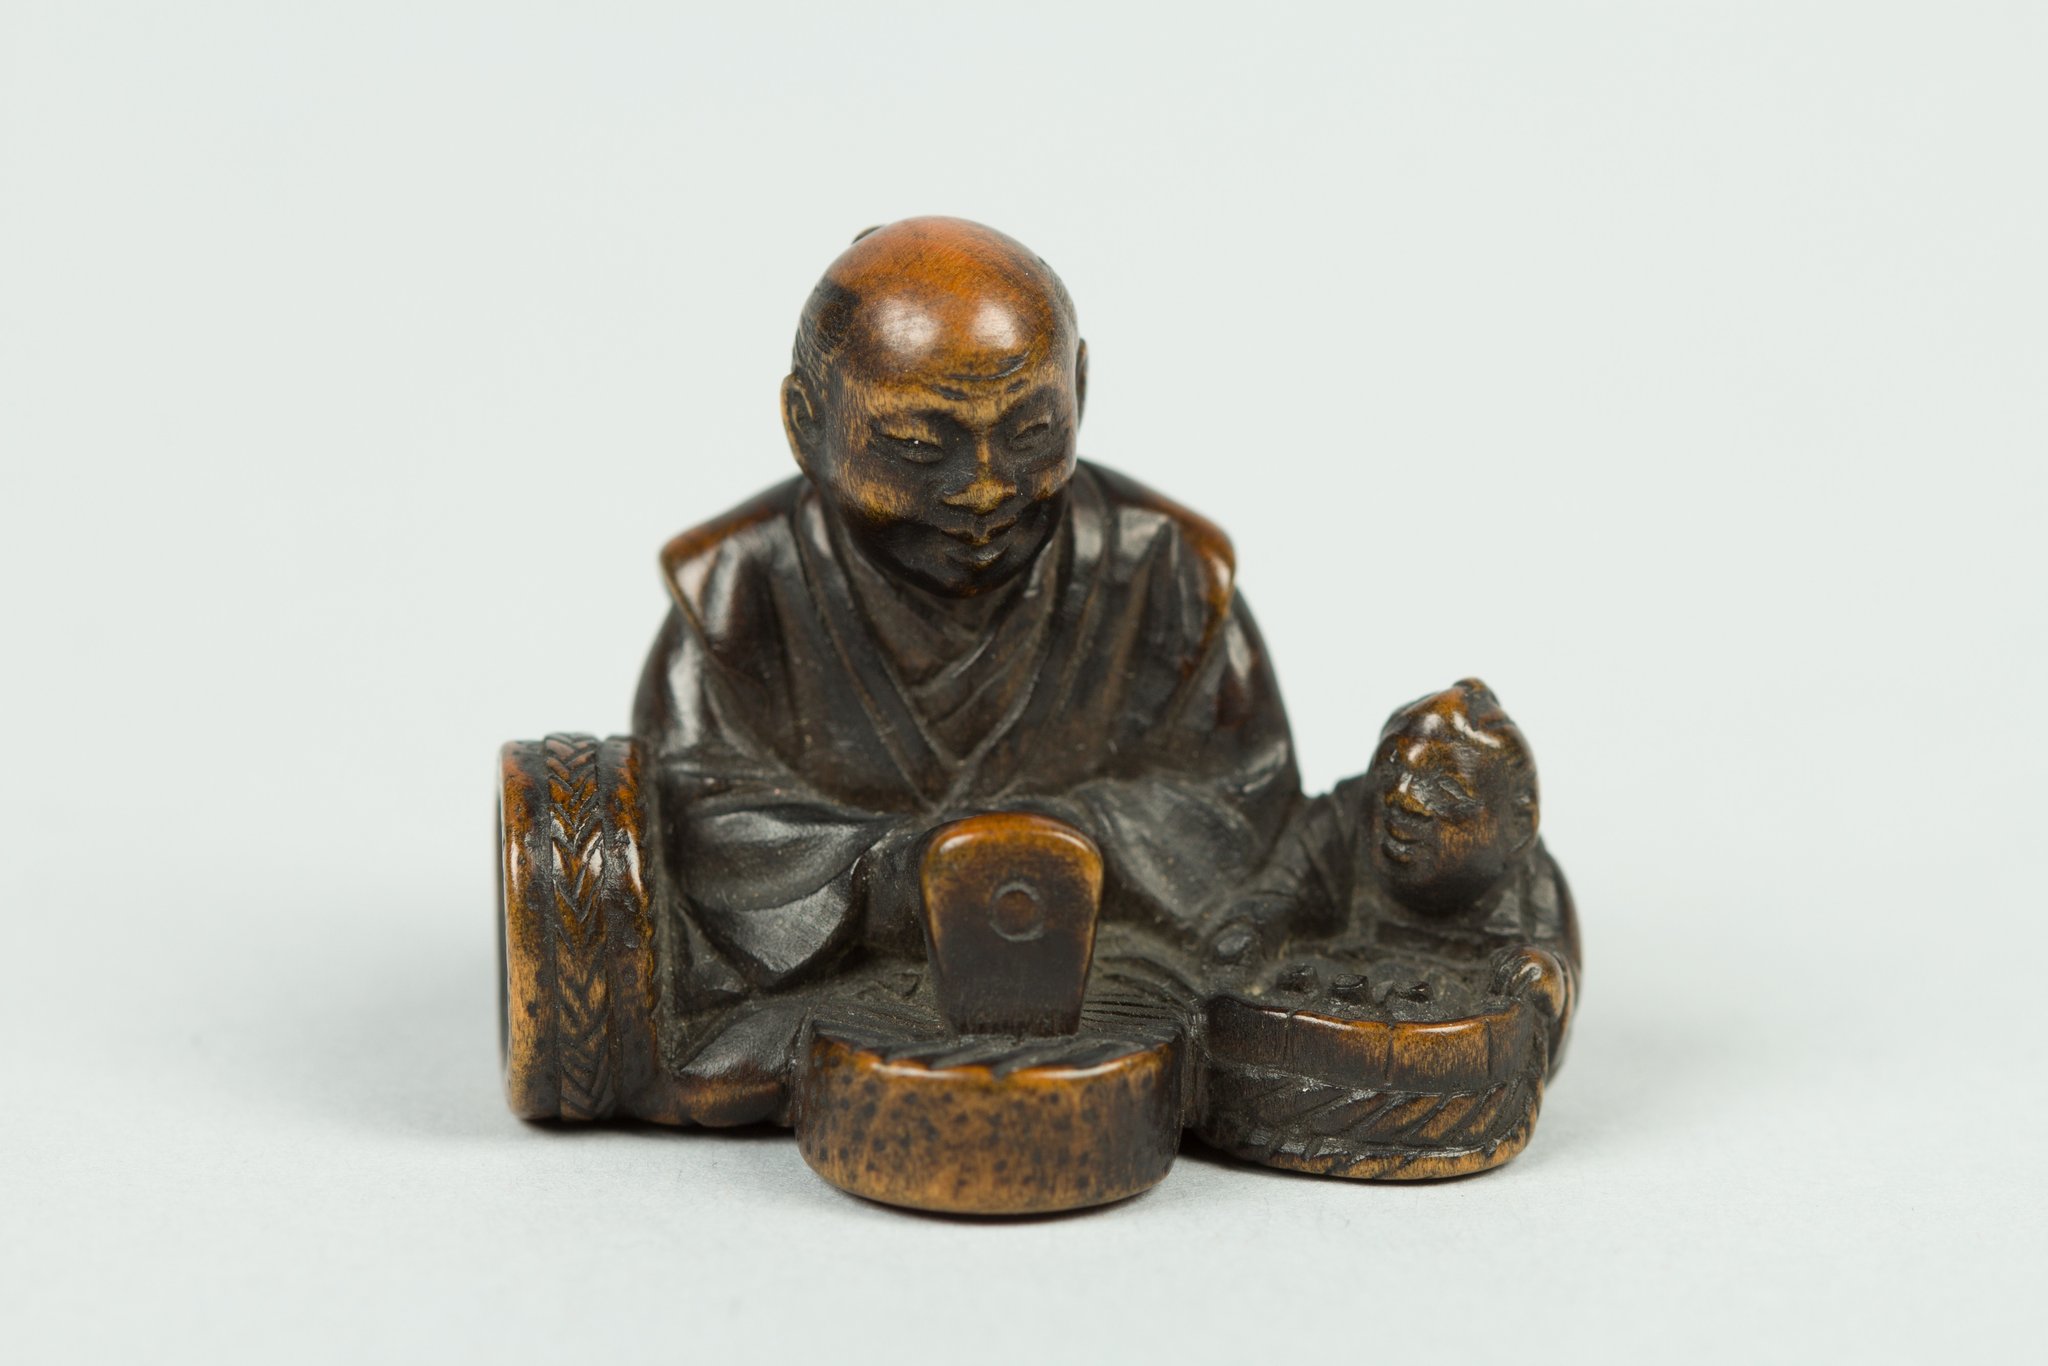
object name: netsuke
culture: japanese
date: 1701-1800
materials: wood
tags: men